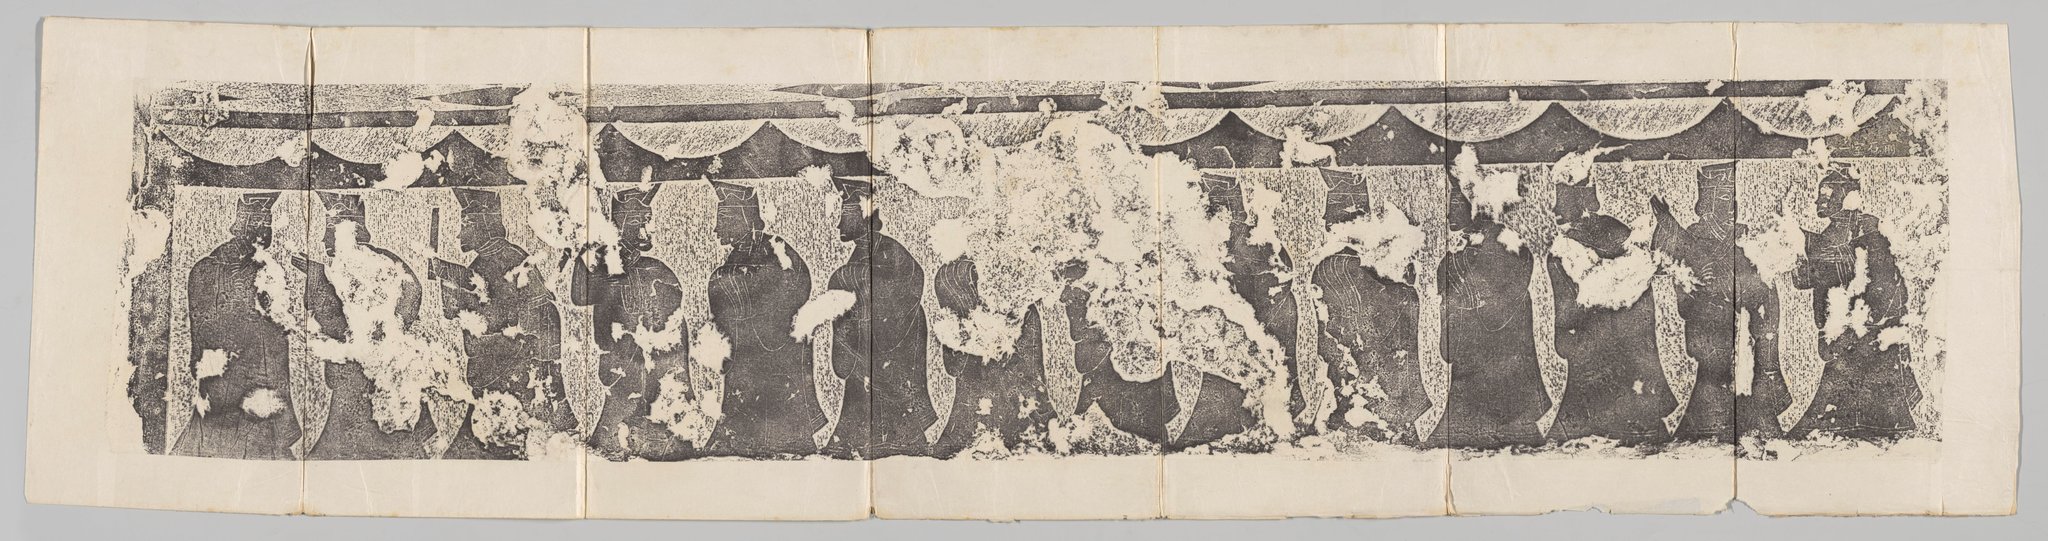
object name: wrijfprent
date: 1900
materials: ink, paper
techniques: rubbing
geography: china